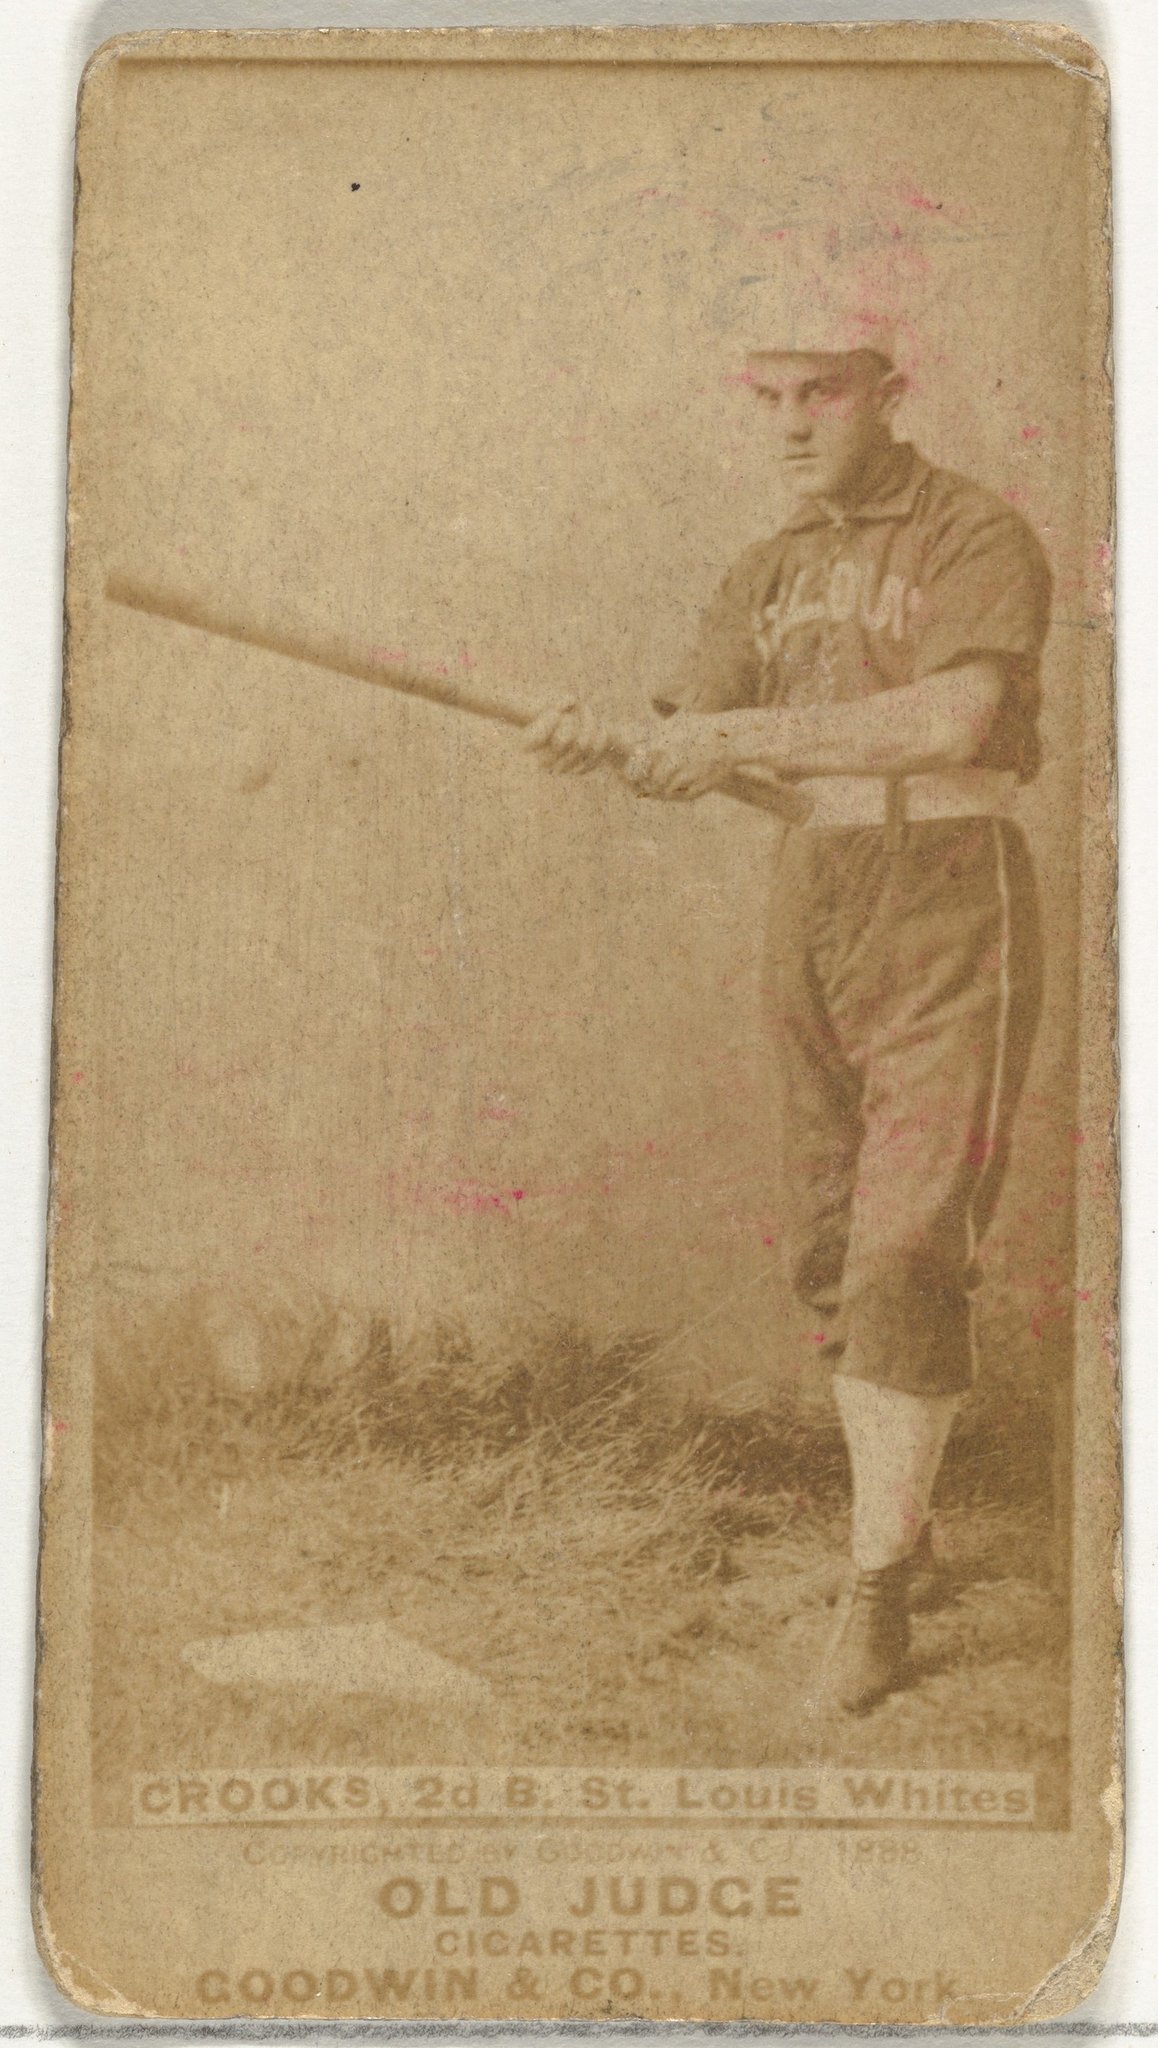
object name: baseball card, photograph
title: Crooks, 2nd Base, St. Louis Whites, from the Old Judge series (N172) for Old Judge Cigarettes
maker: goodwin & company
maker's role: publisher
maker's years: 1850-1950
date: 1888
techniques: albumen silver print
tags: men,portraits,baseball,athletes